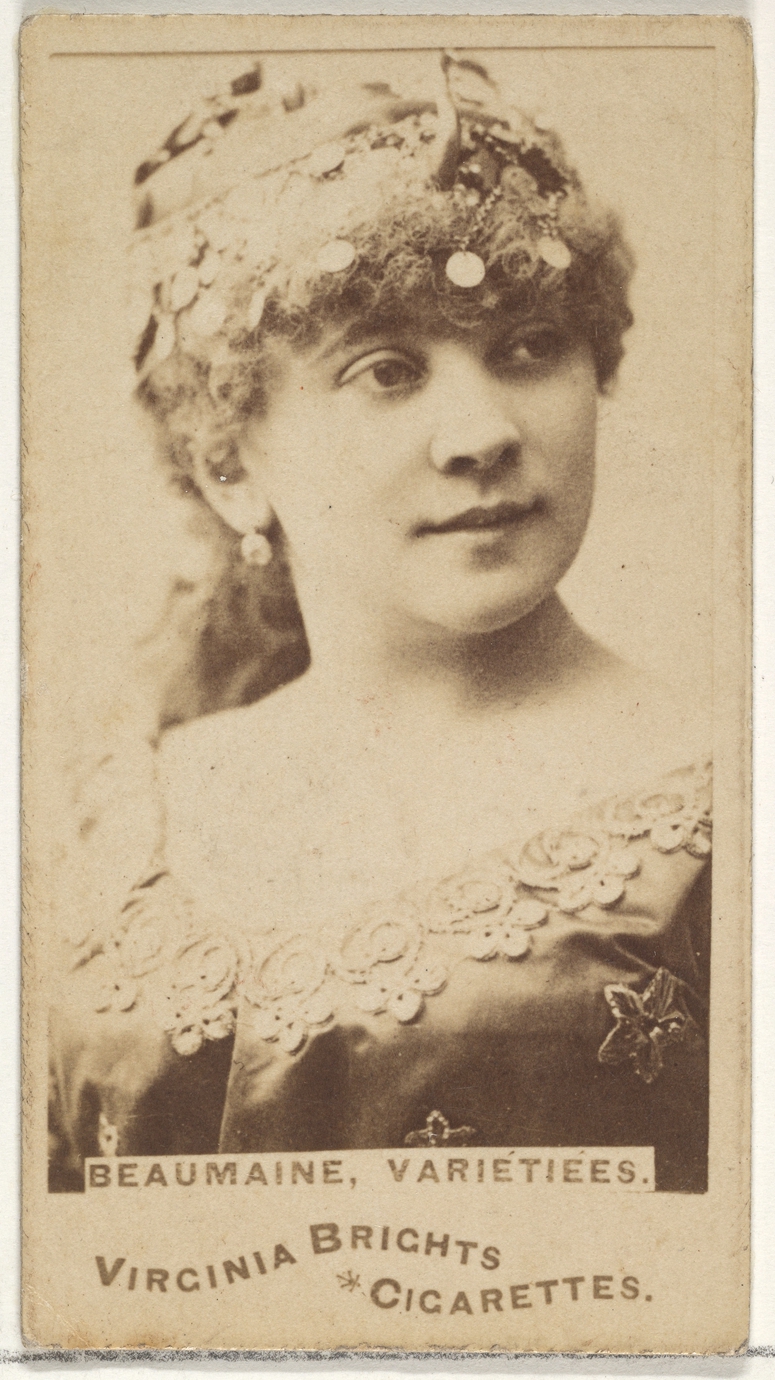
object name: photograph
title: Beaumaine, Varietiees, from the Actors and Actresses series (N45, Type 1) for Virginia Brights Cigarettes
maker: allen & ginter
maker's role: publisher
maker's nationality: american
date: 1888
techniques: albumen silver print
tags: portraits,women,actresses